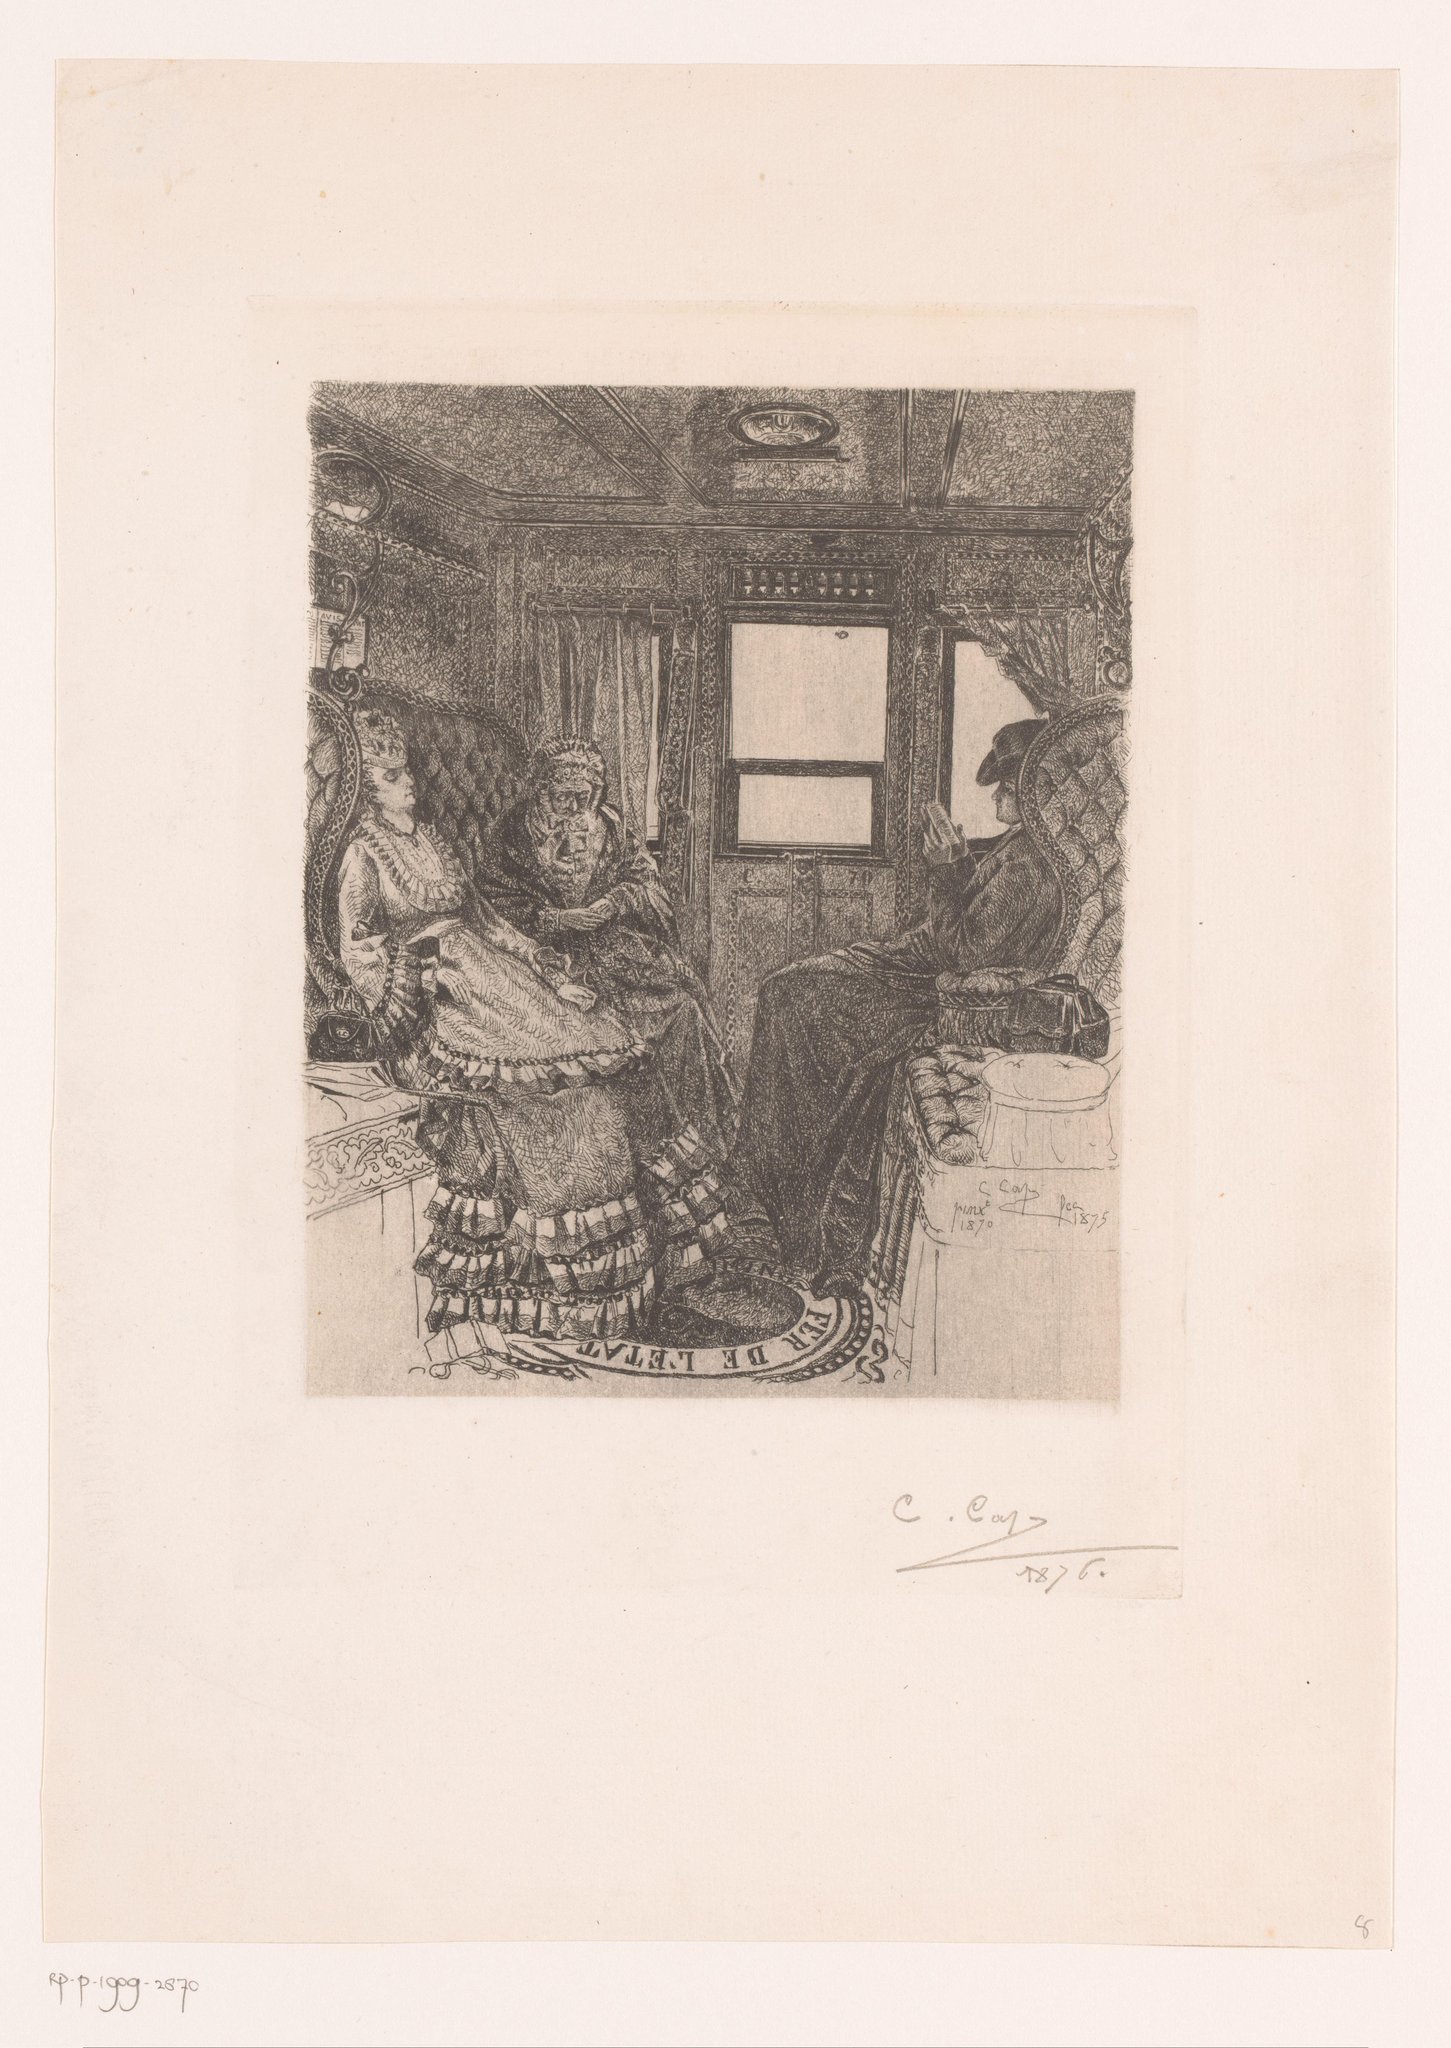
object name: print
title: Drie dames in een treincoupé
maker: constant aimé marie cap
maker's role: print maker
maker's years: 1842-1915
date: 1875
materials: paper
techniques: etching, intaglio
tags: passenger train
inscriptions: collector's mark: Lugt 2228